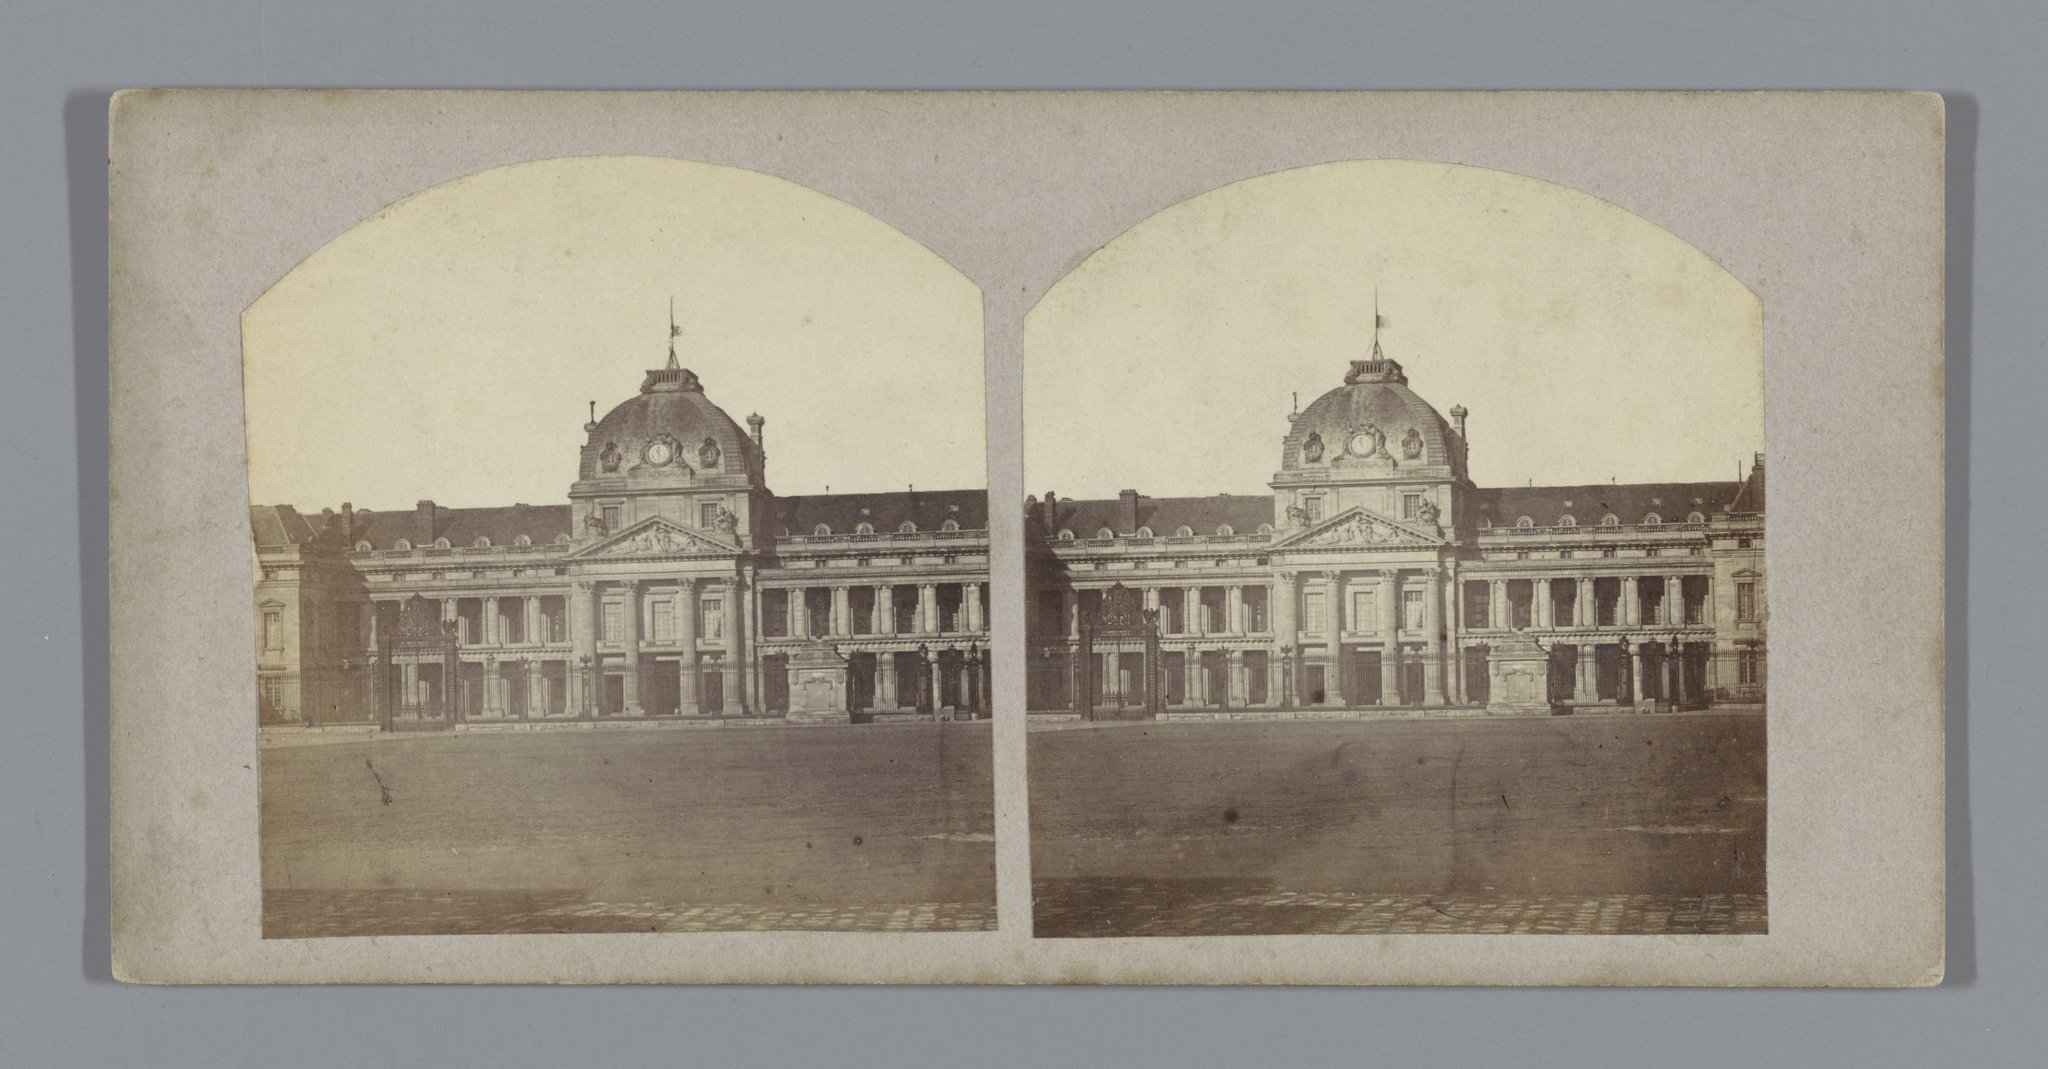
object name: stereograph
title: École militaire de Paris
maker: Anonymous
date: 1860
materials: cardboard, photographic support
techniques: albumen print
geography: paris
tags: military academy, tuileries palace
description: Gezicht op de façade van de Militaire academie aan de kant van Place de Fontenoy te Parijs.